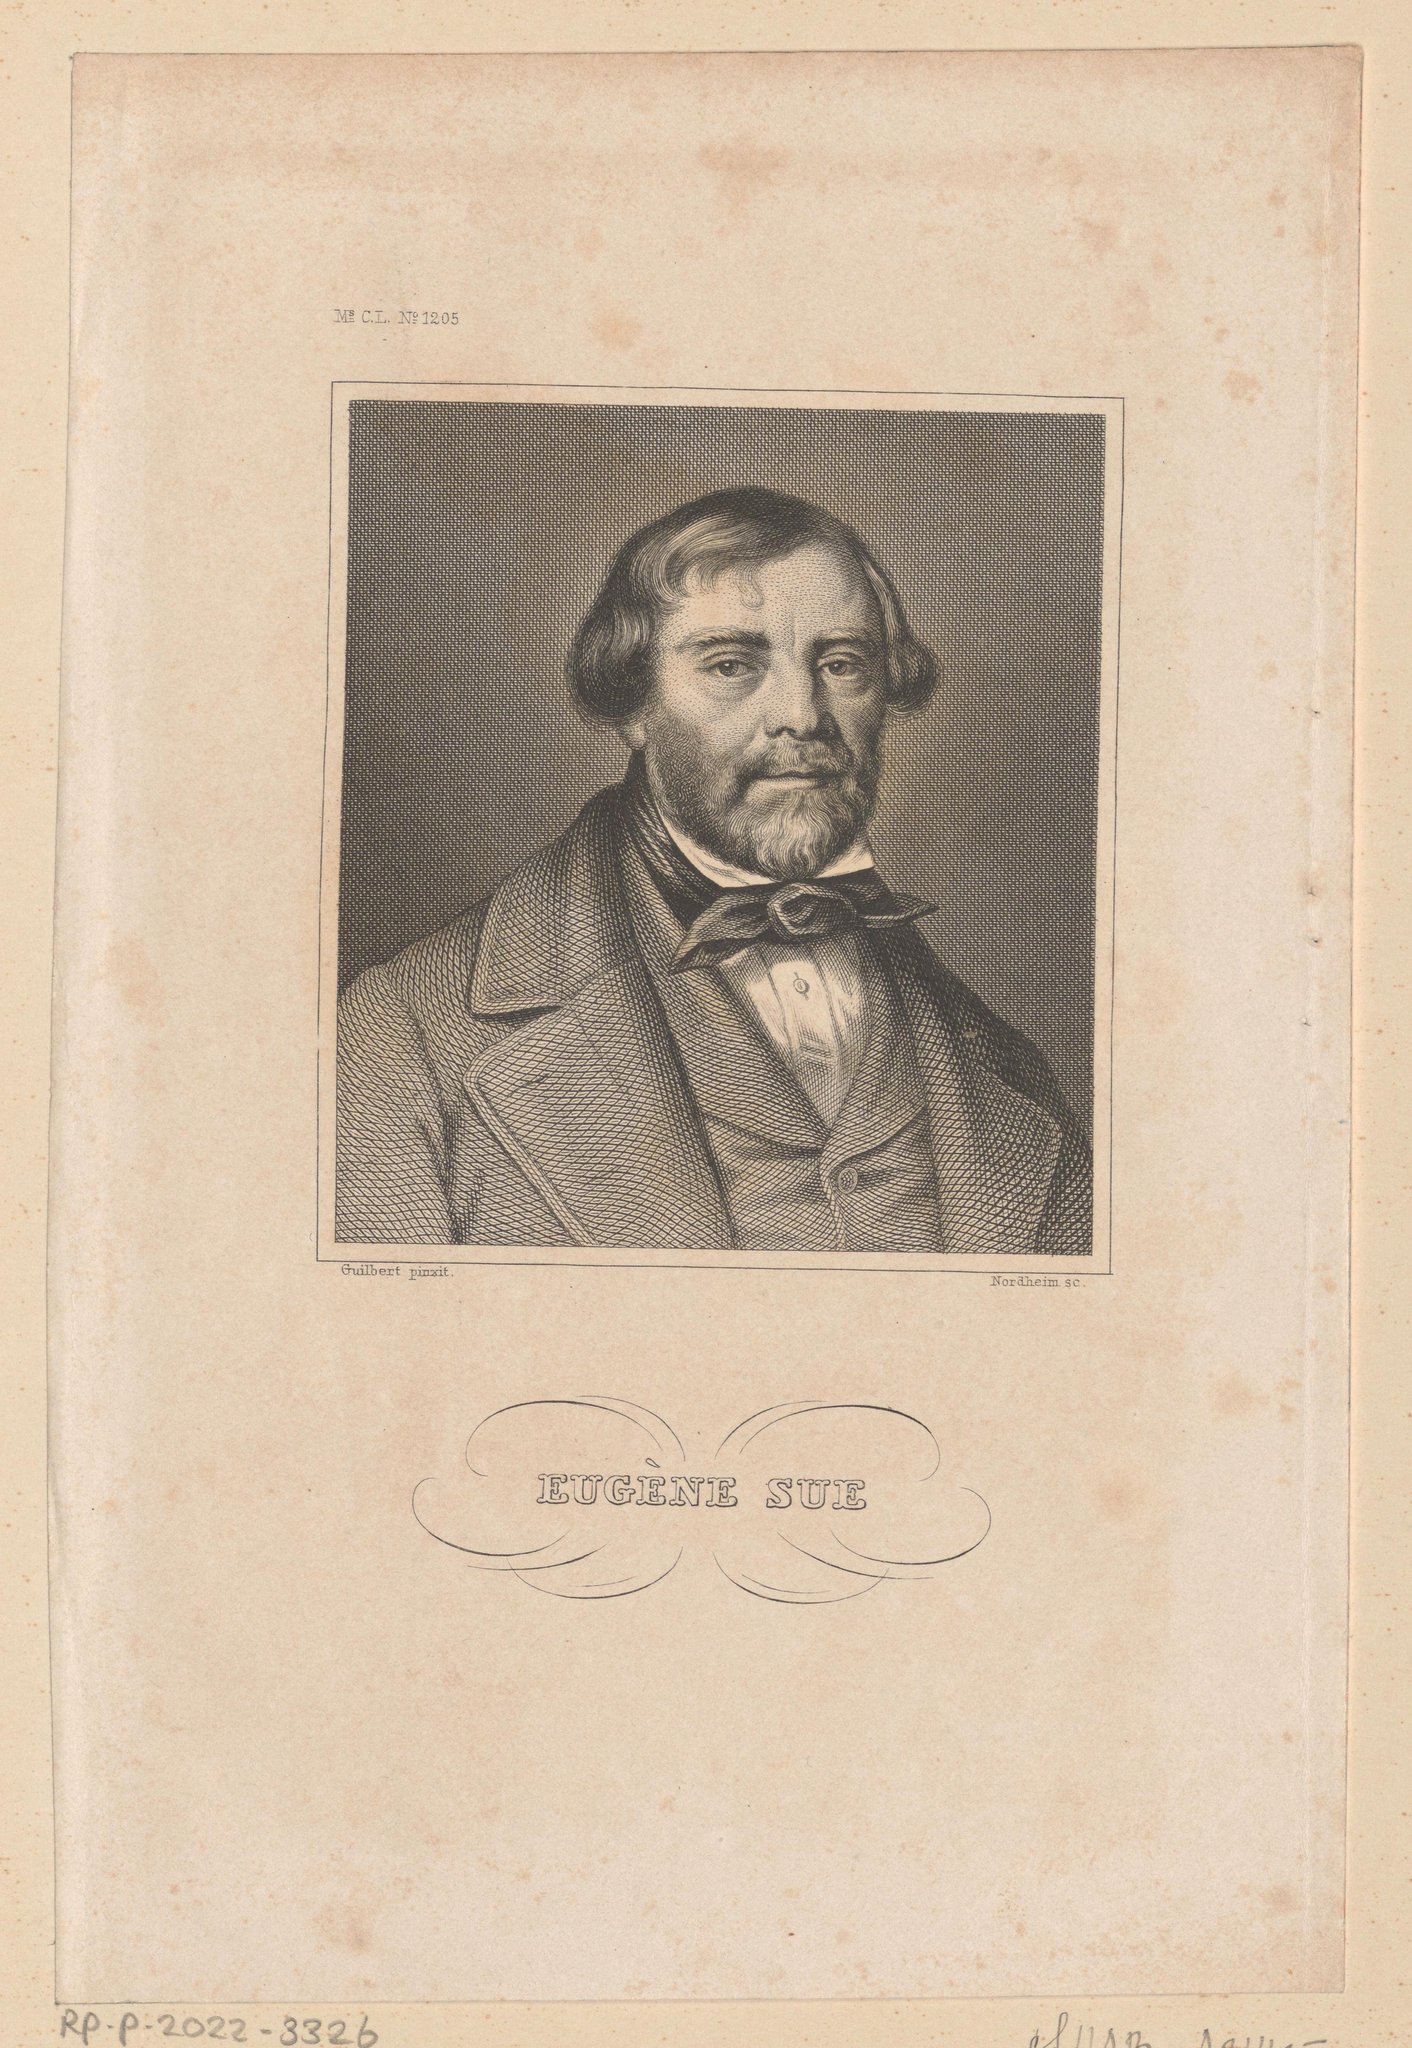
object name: print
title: Portret van Eugène Sue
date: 1852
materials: paper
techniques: engraving, etching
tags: historical persons, portrait of a writer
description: Prent waarschijnlijk uit: Meyer, Hermann Julius. Das grosse Conversations-Lexicon für die gebildeten Stände. Amsterdam, Parijs en Philidelphia: Bibliographisches Institut, 1852. dl. 40. p. 840. Prent in eerdere staat gebruikt voor de serie Zeitgenossen.